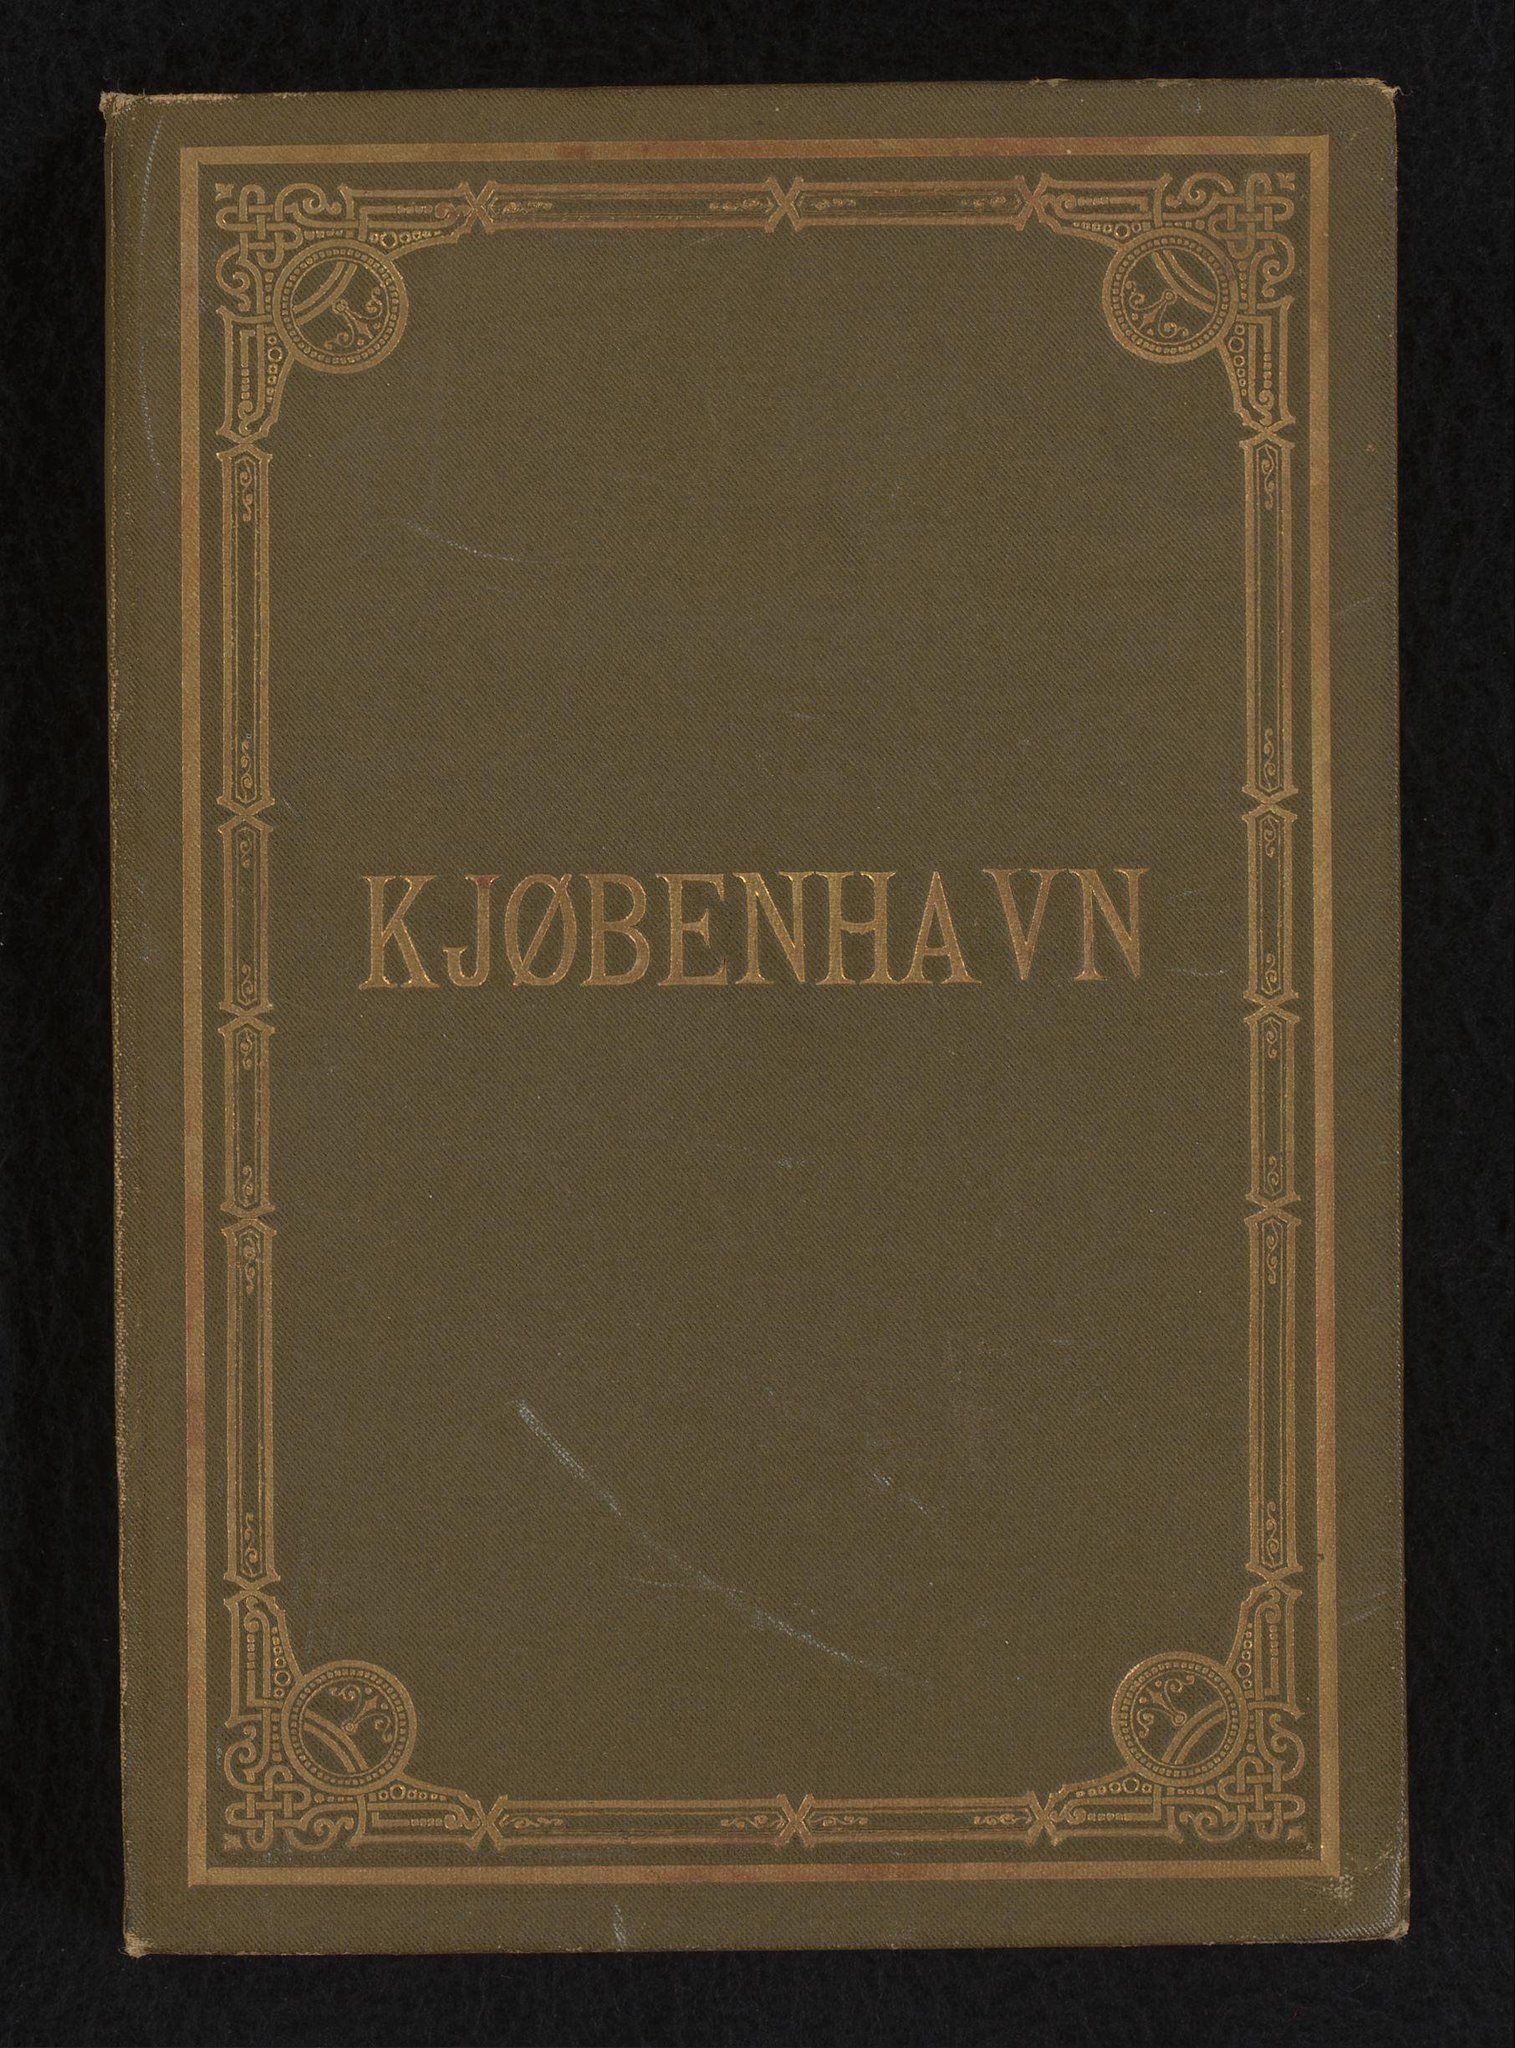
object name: accordion book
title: Kjobenhavn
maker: vilhelm trydes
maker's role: publisher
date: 1880-1920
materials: cardboard, linen, paper, photographic support, tape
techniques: collodion silver print, gold embossing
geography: copenhagen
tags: palace, interior of church, street, prospect of city, town panorama, silhouette of city, copenhagen (city)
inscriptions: number: ‘8.90’, collector's mark: ‘DIENST/ VERSPREIDE/ RIJKSKOLLEKTIES/ (...) A 965’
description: Leporelloalbum met twaalf stadsgezichten op Kopenhagen. Afgebeeld zijn onder andere de Rosenborg, Amalienborg en het interieur van de Onze-Lieve-Vrouwekerk.